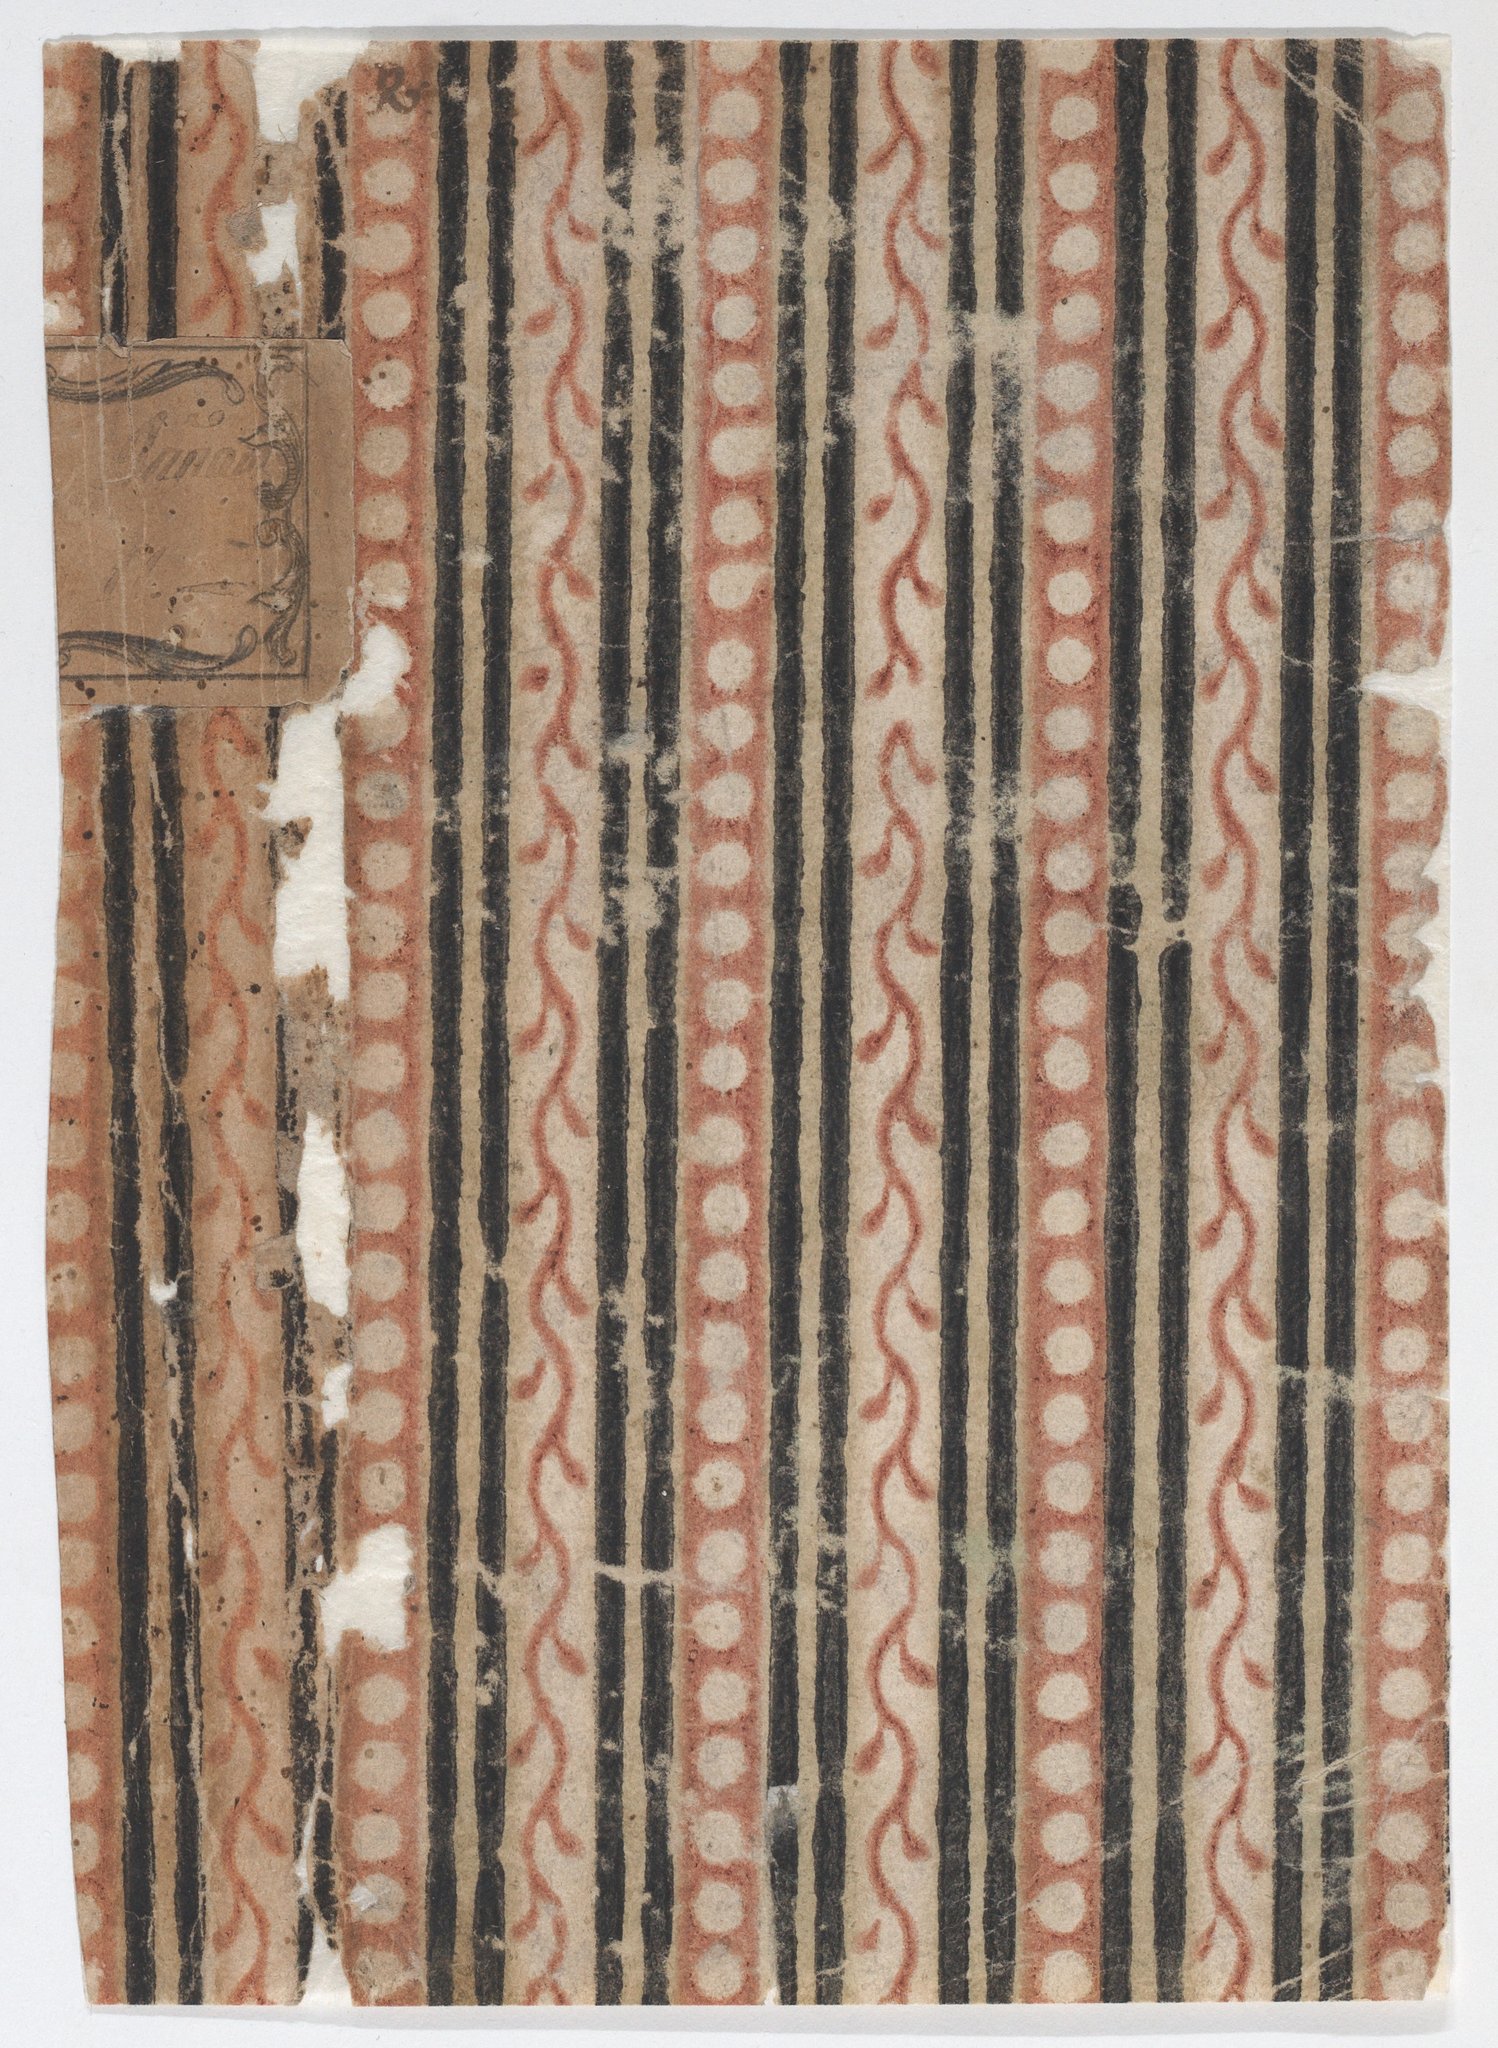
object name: print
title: Right side of a book cover with pattern of stripes, vines, and dots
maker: Anonymous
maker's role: artist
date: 1801-1900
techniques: relief print